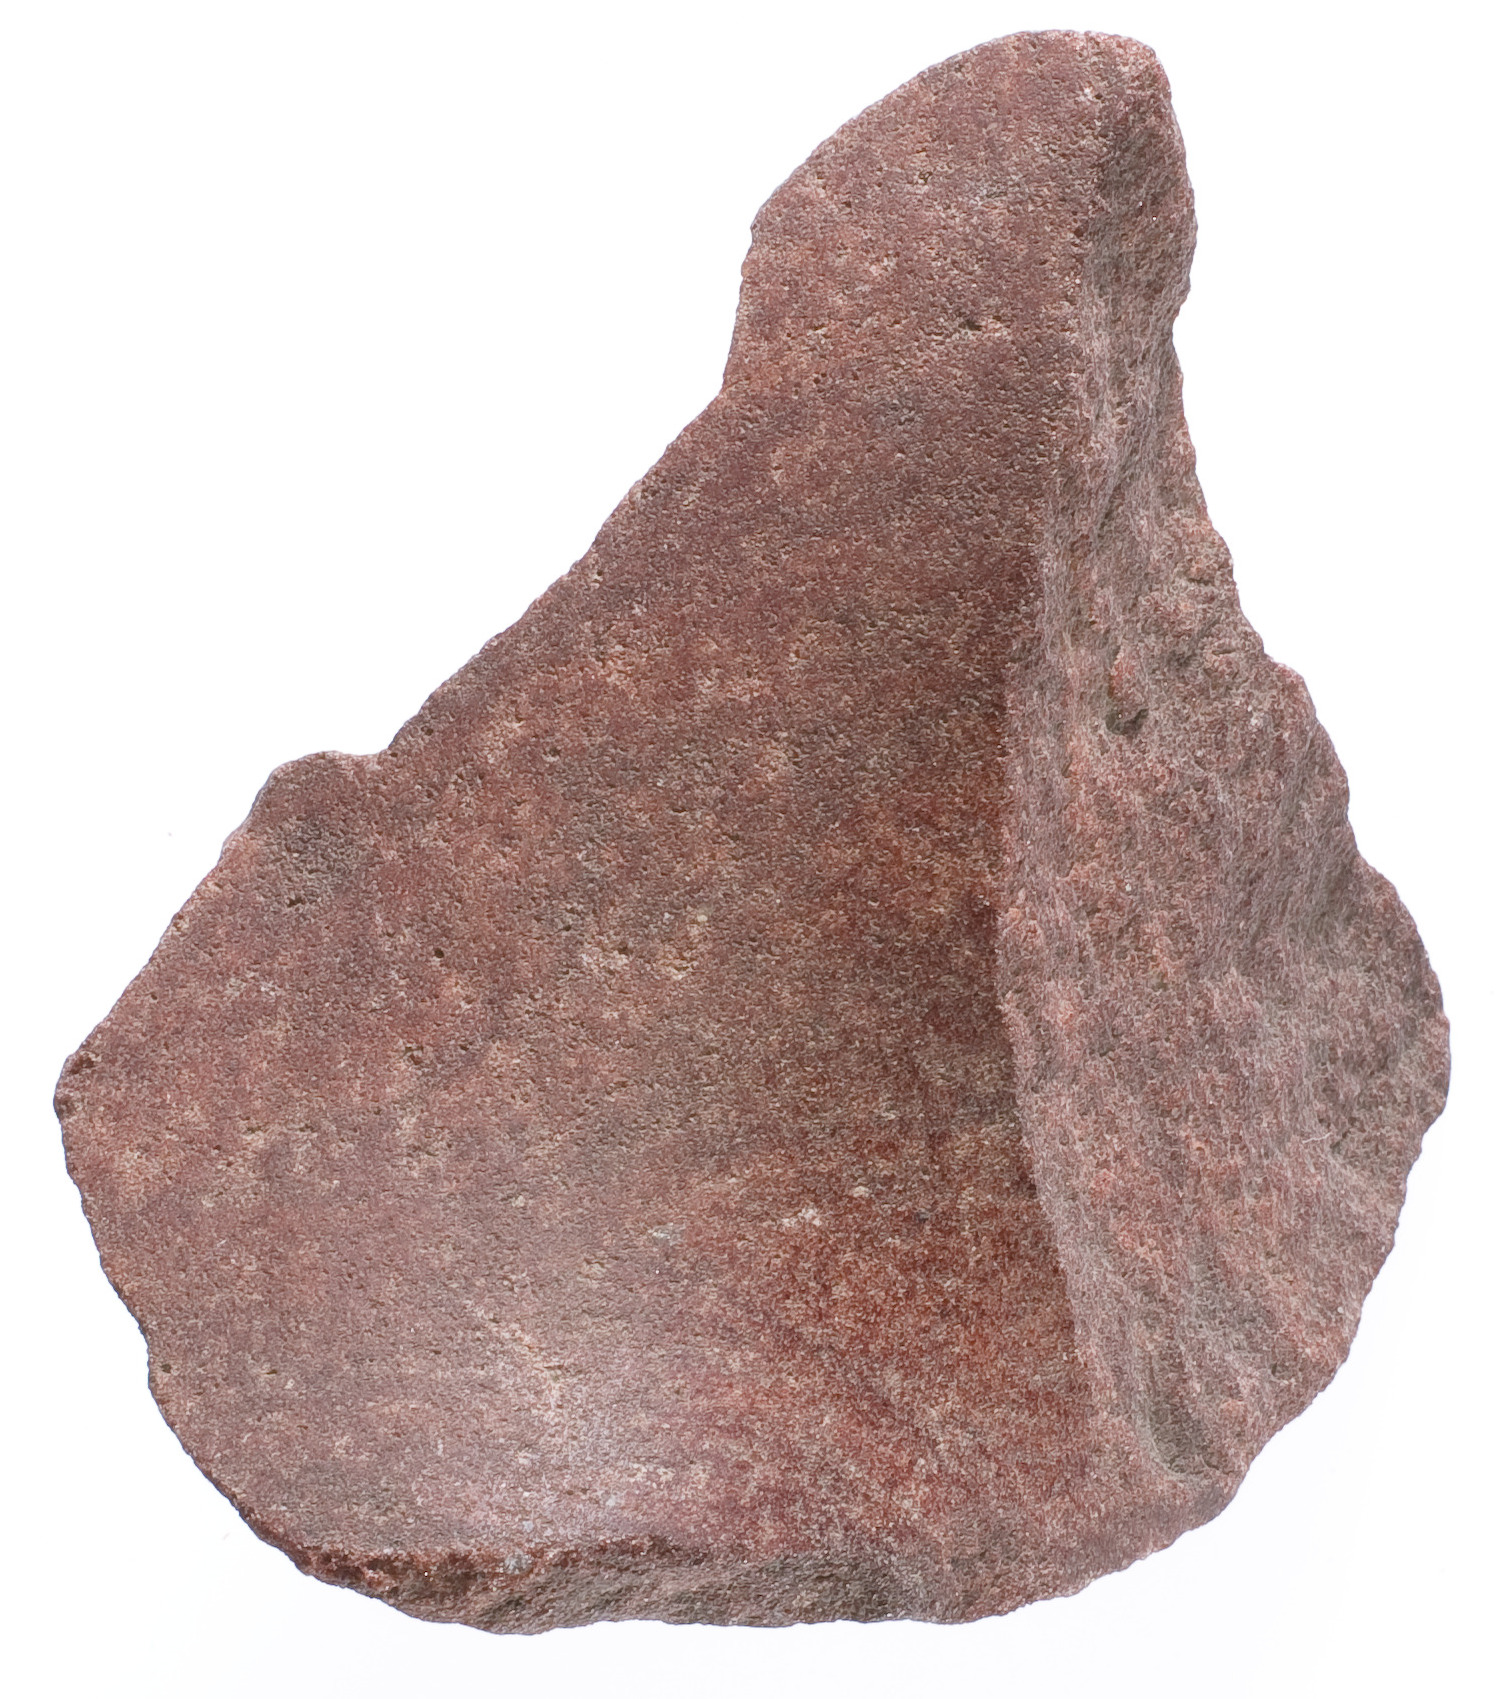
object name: flesh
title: Flesh area from a statue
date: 1353-1336 BCE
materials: quartzite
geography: egypt